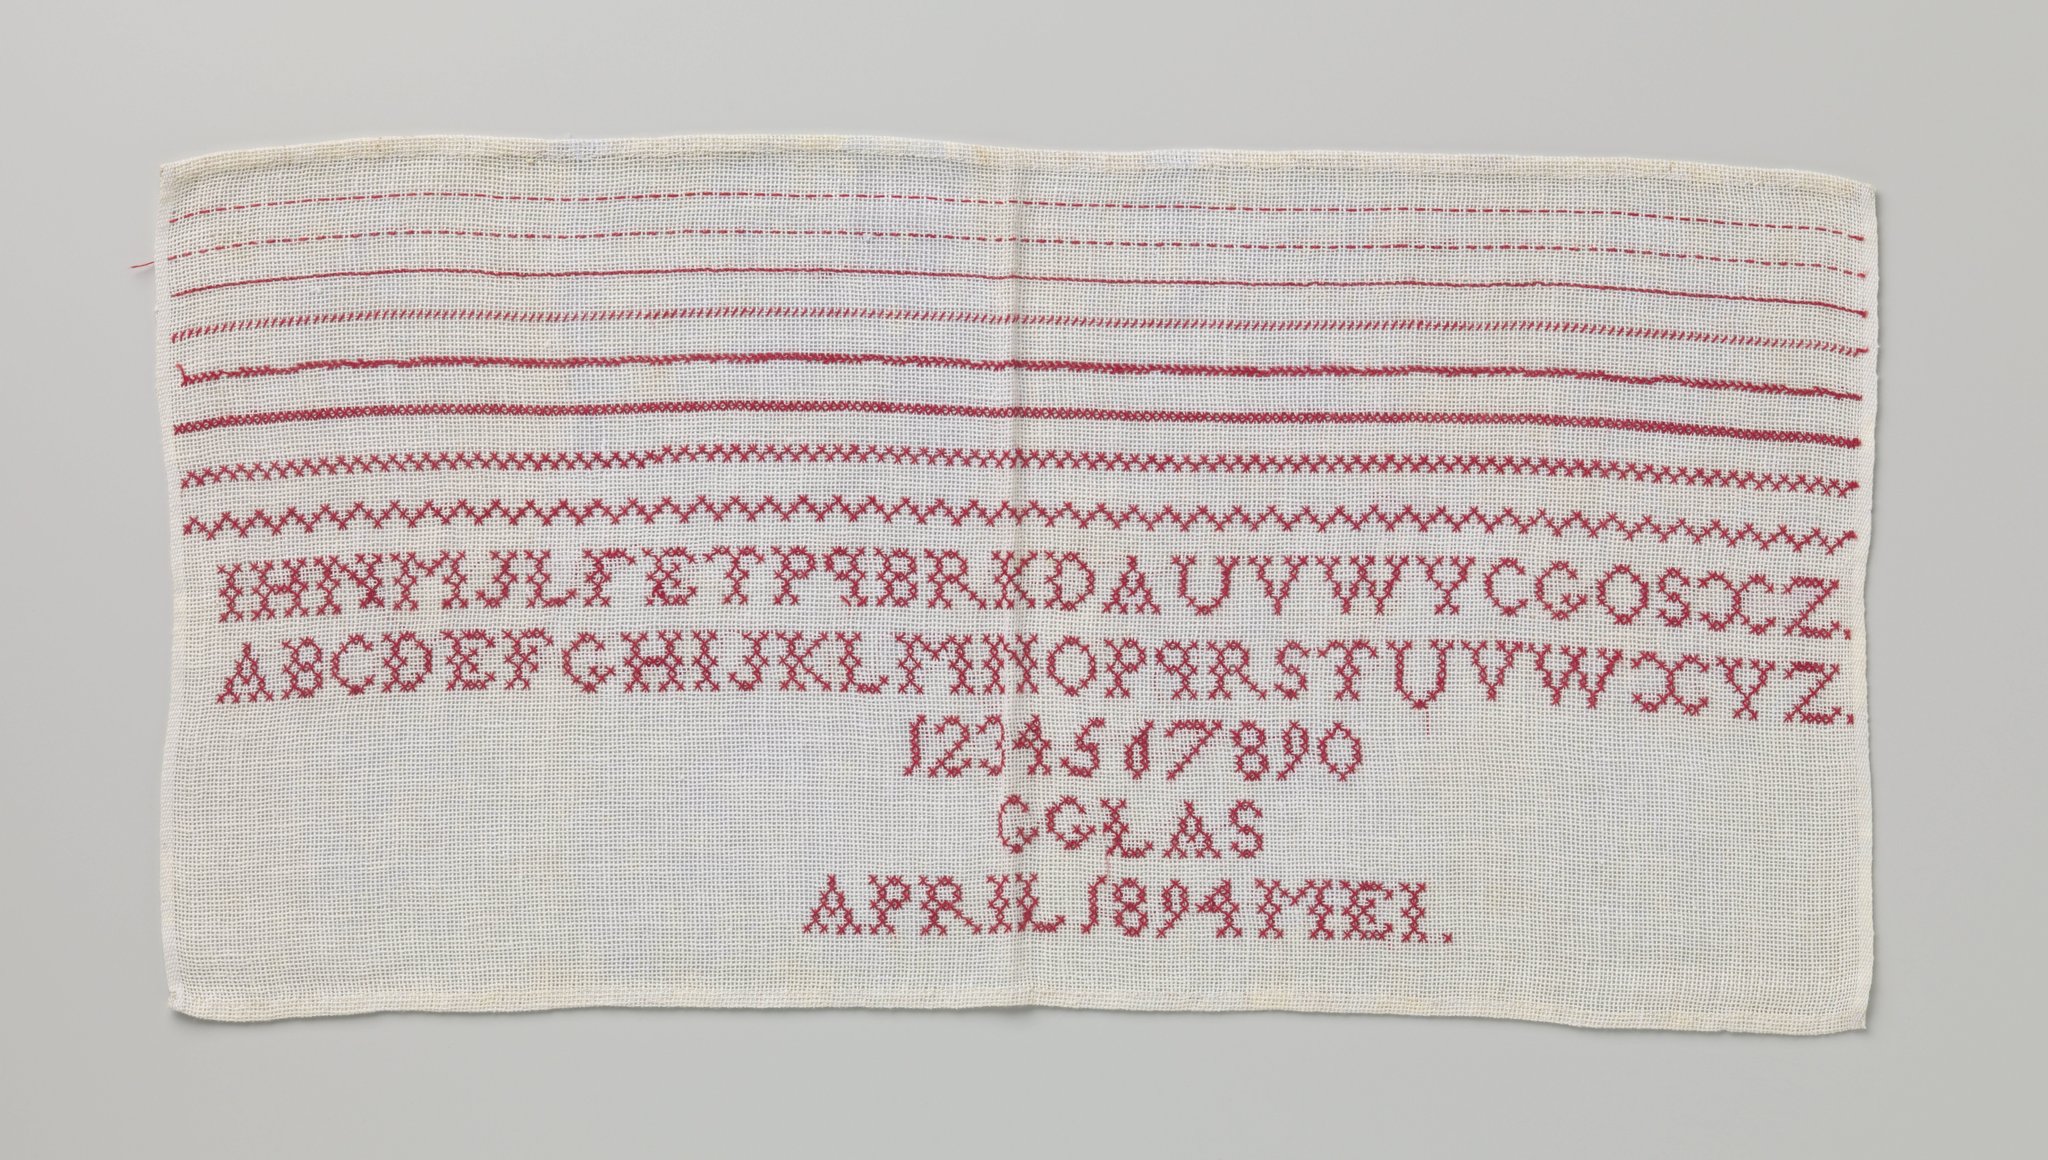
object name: merkdoek, merklap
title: Merklap van linnen met een stramien van rode letters en cijfers, gemerkt: 'G. Glas april 1894 mei"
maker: g. glas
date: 1894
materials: linen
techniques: embroidered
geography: deventer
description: Vervaardigd op de Normaalschool te Deventer voor de akte 'Nuttige handwerken'.